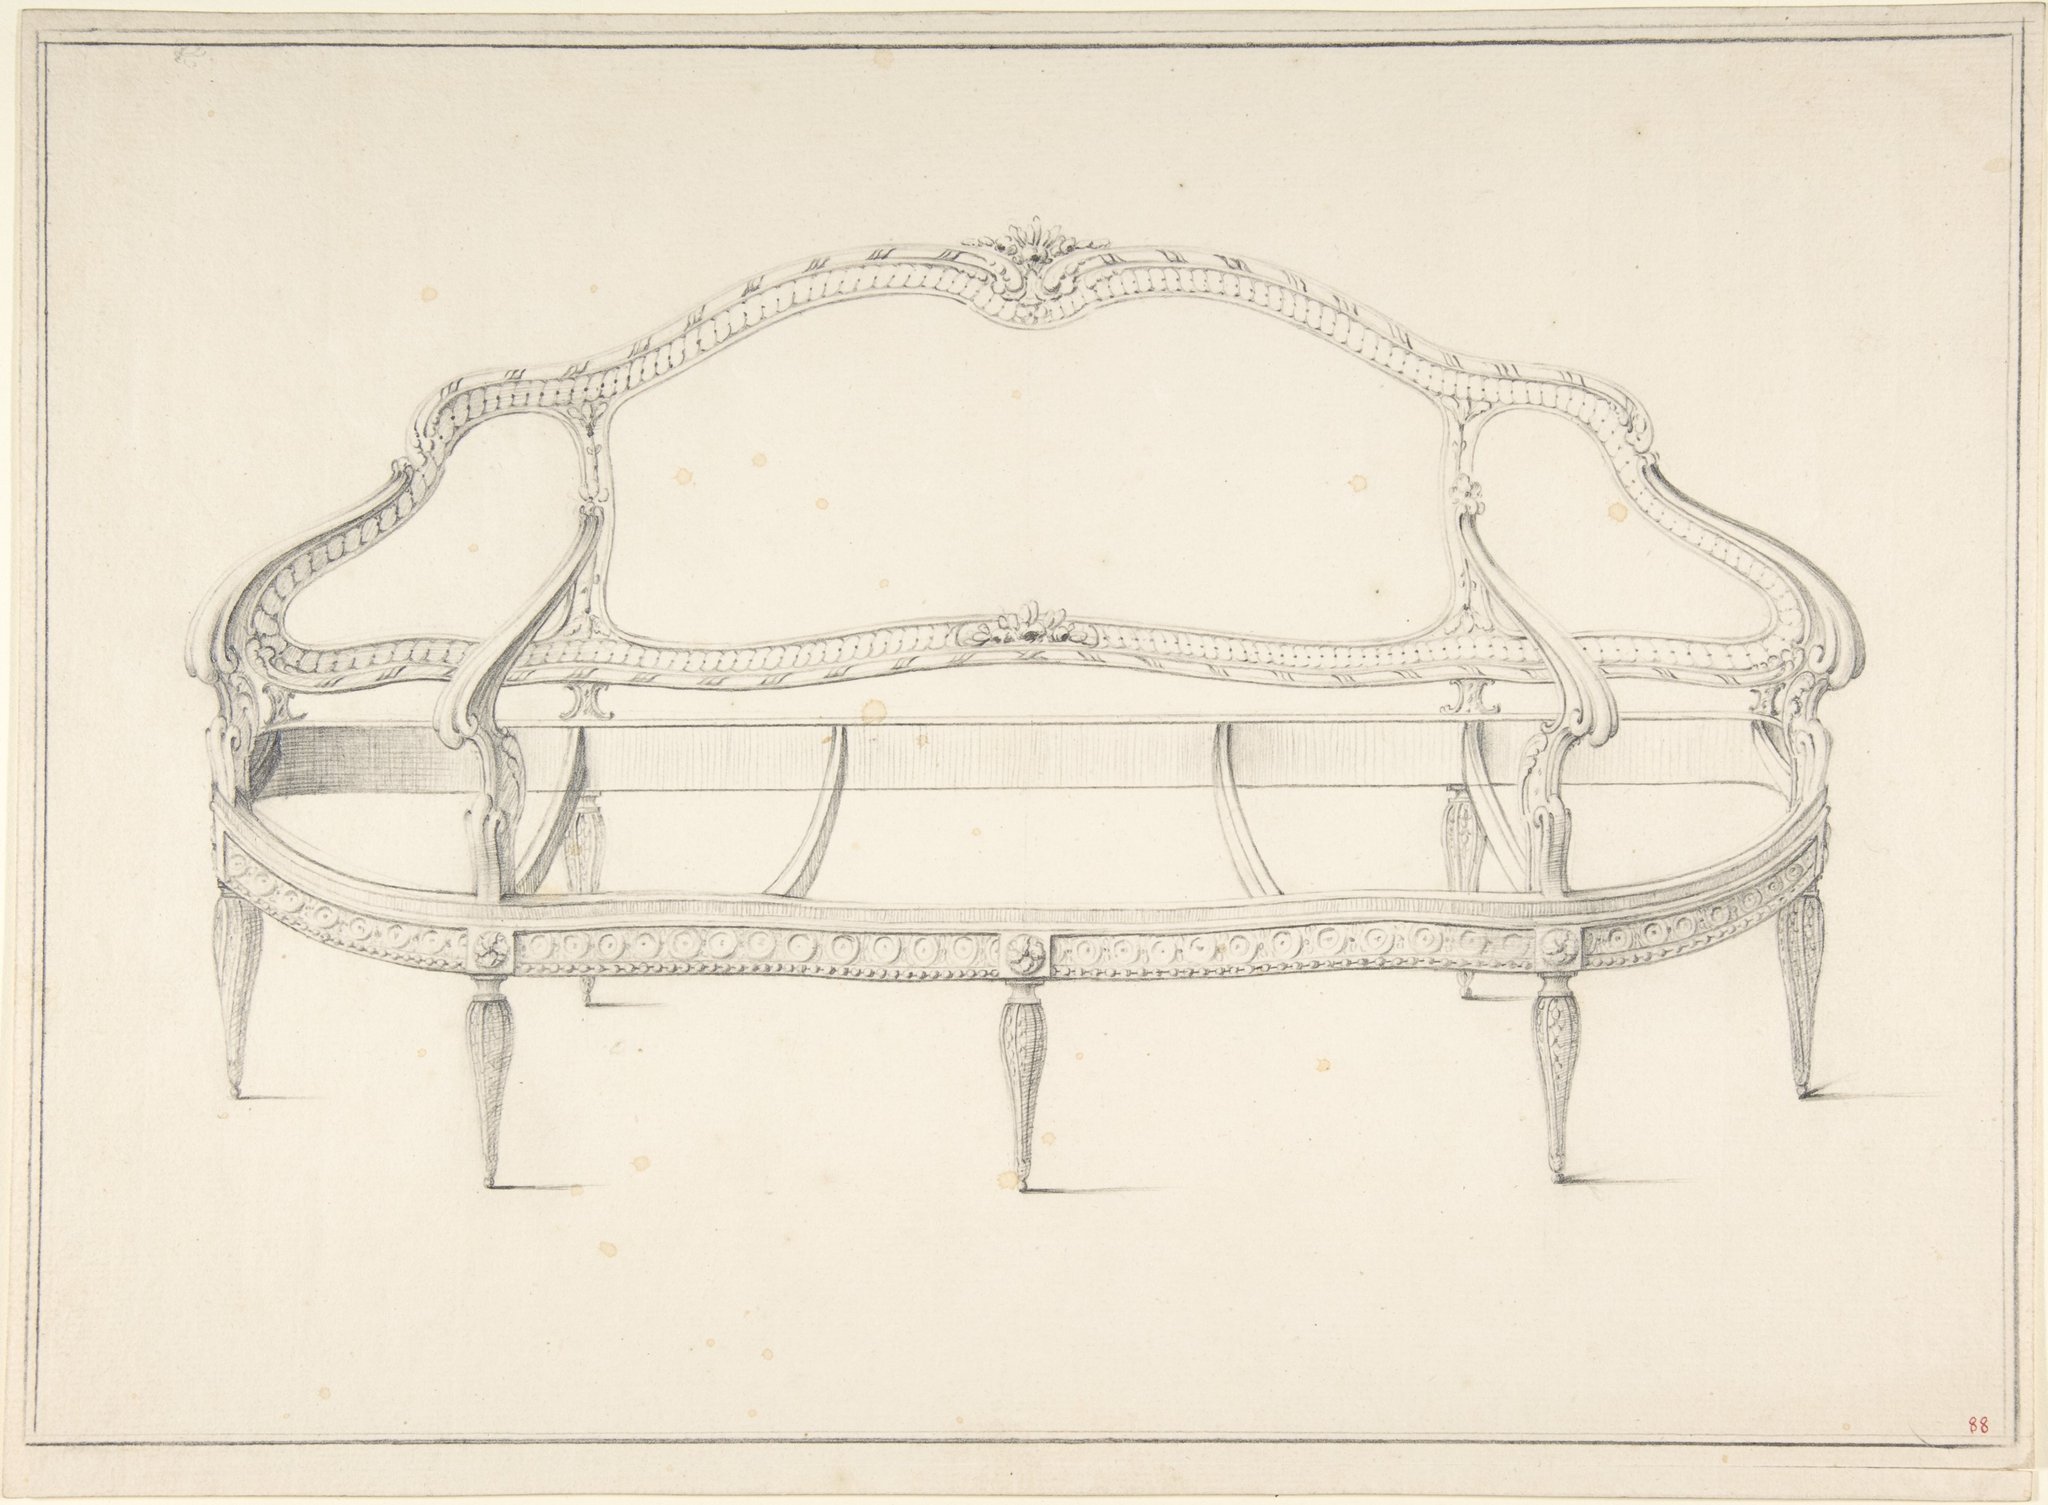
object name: drawing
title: Design for a Settee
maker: anonymous, french, 18th century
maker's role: artist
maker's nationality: french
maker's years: 1700-1800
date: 1770-1790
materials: graphite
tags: furniture